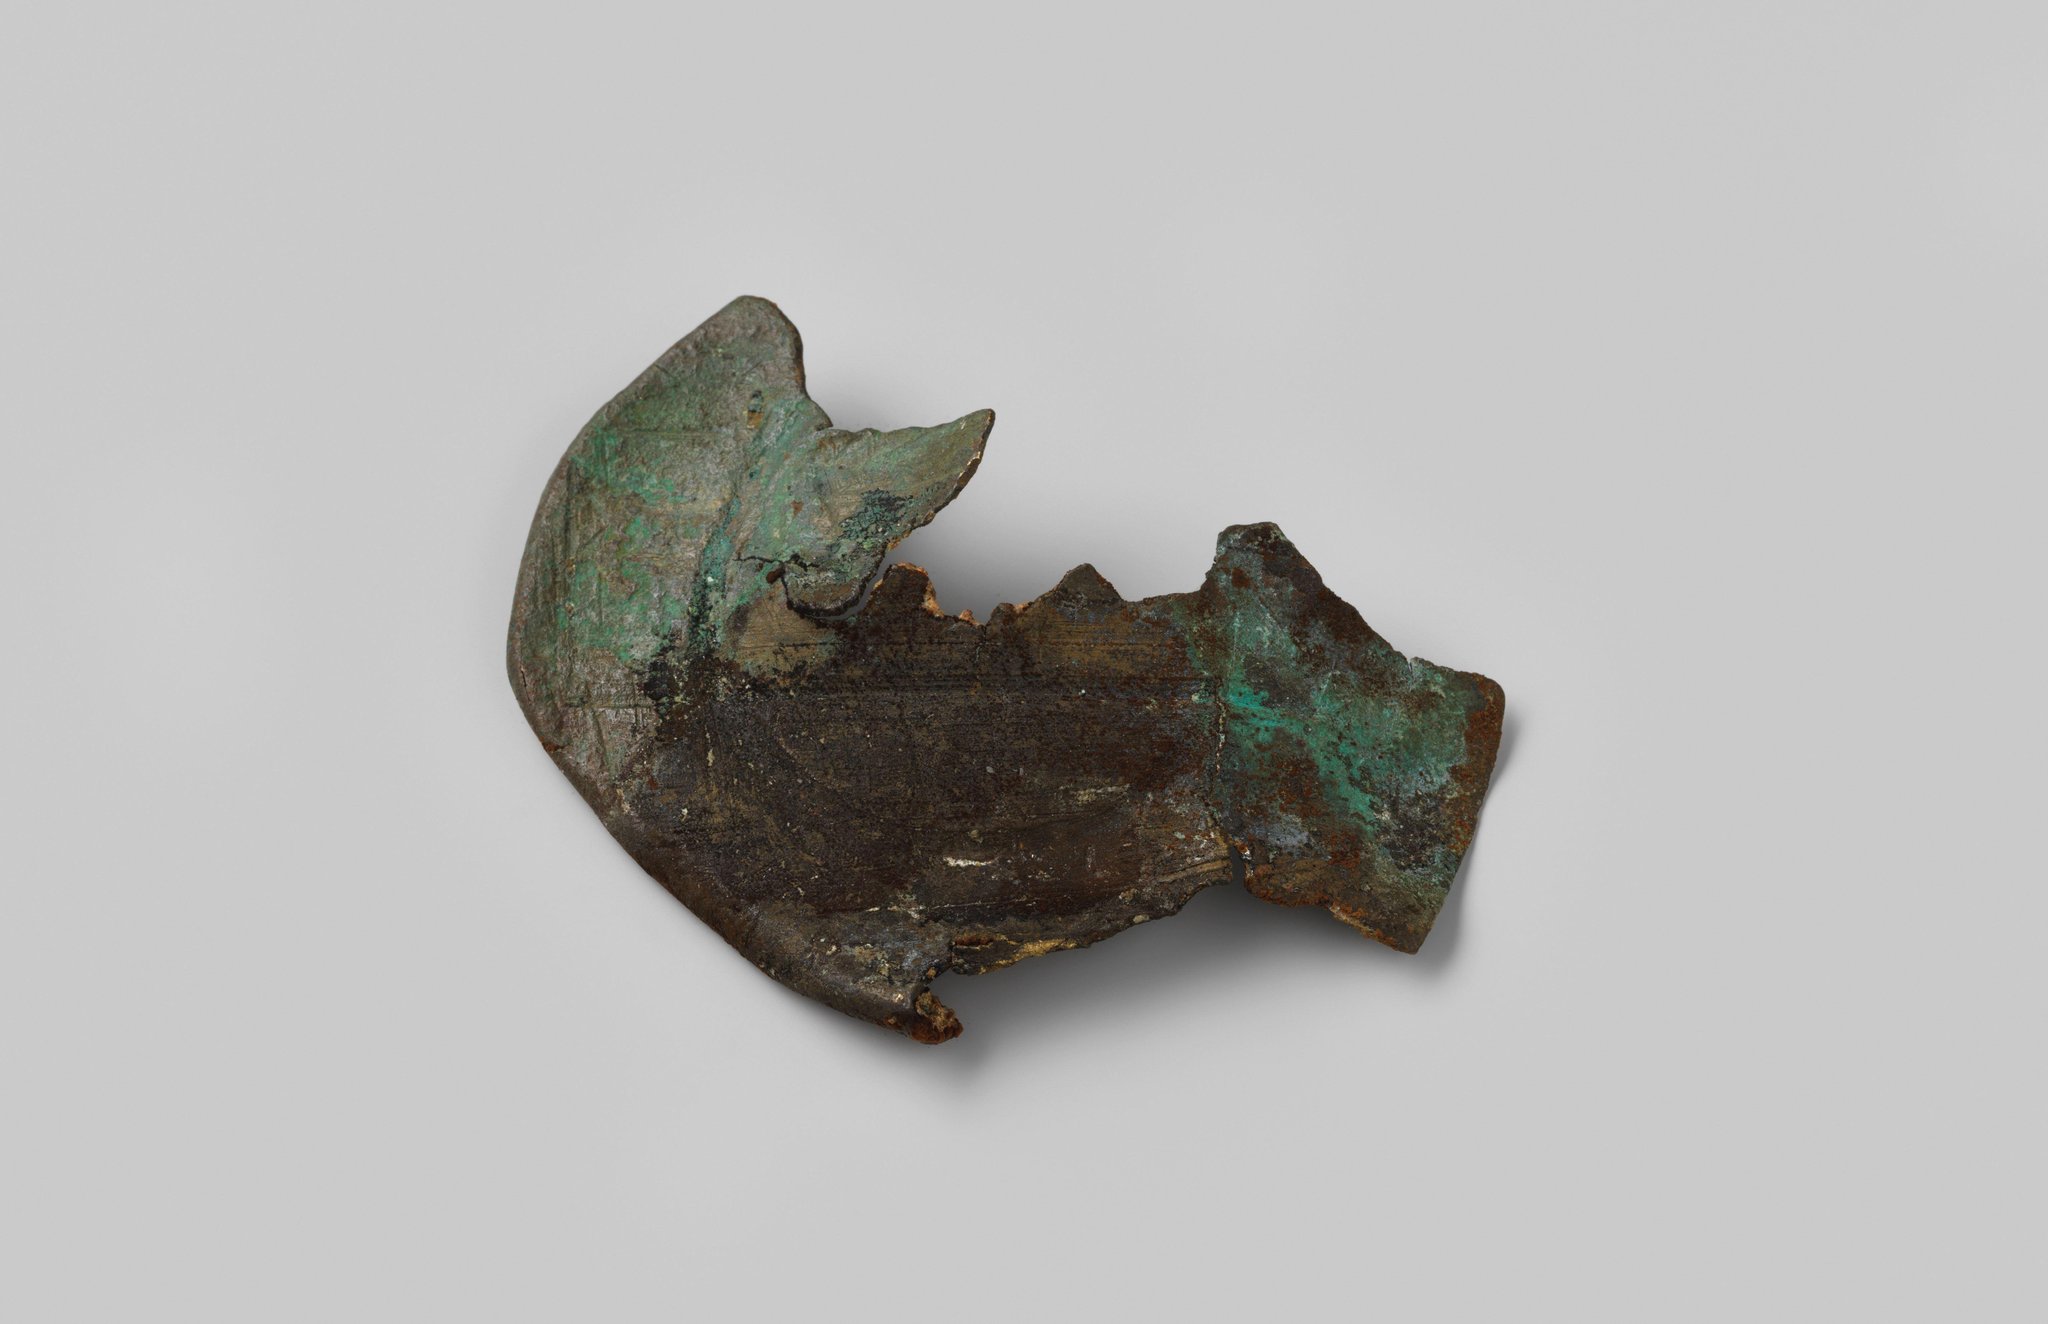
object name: fragment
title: Fragment uit het wrak van de Oost-Indiëvaarder Hollandia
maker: Anonymous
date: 1700-1743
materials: copper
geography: netherlands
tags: verenigde oostindische compagnie, hollandia (schip), annet